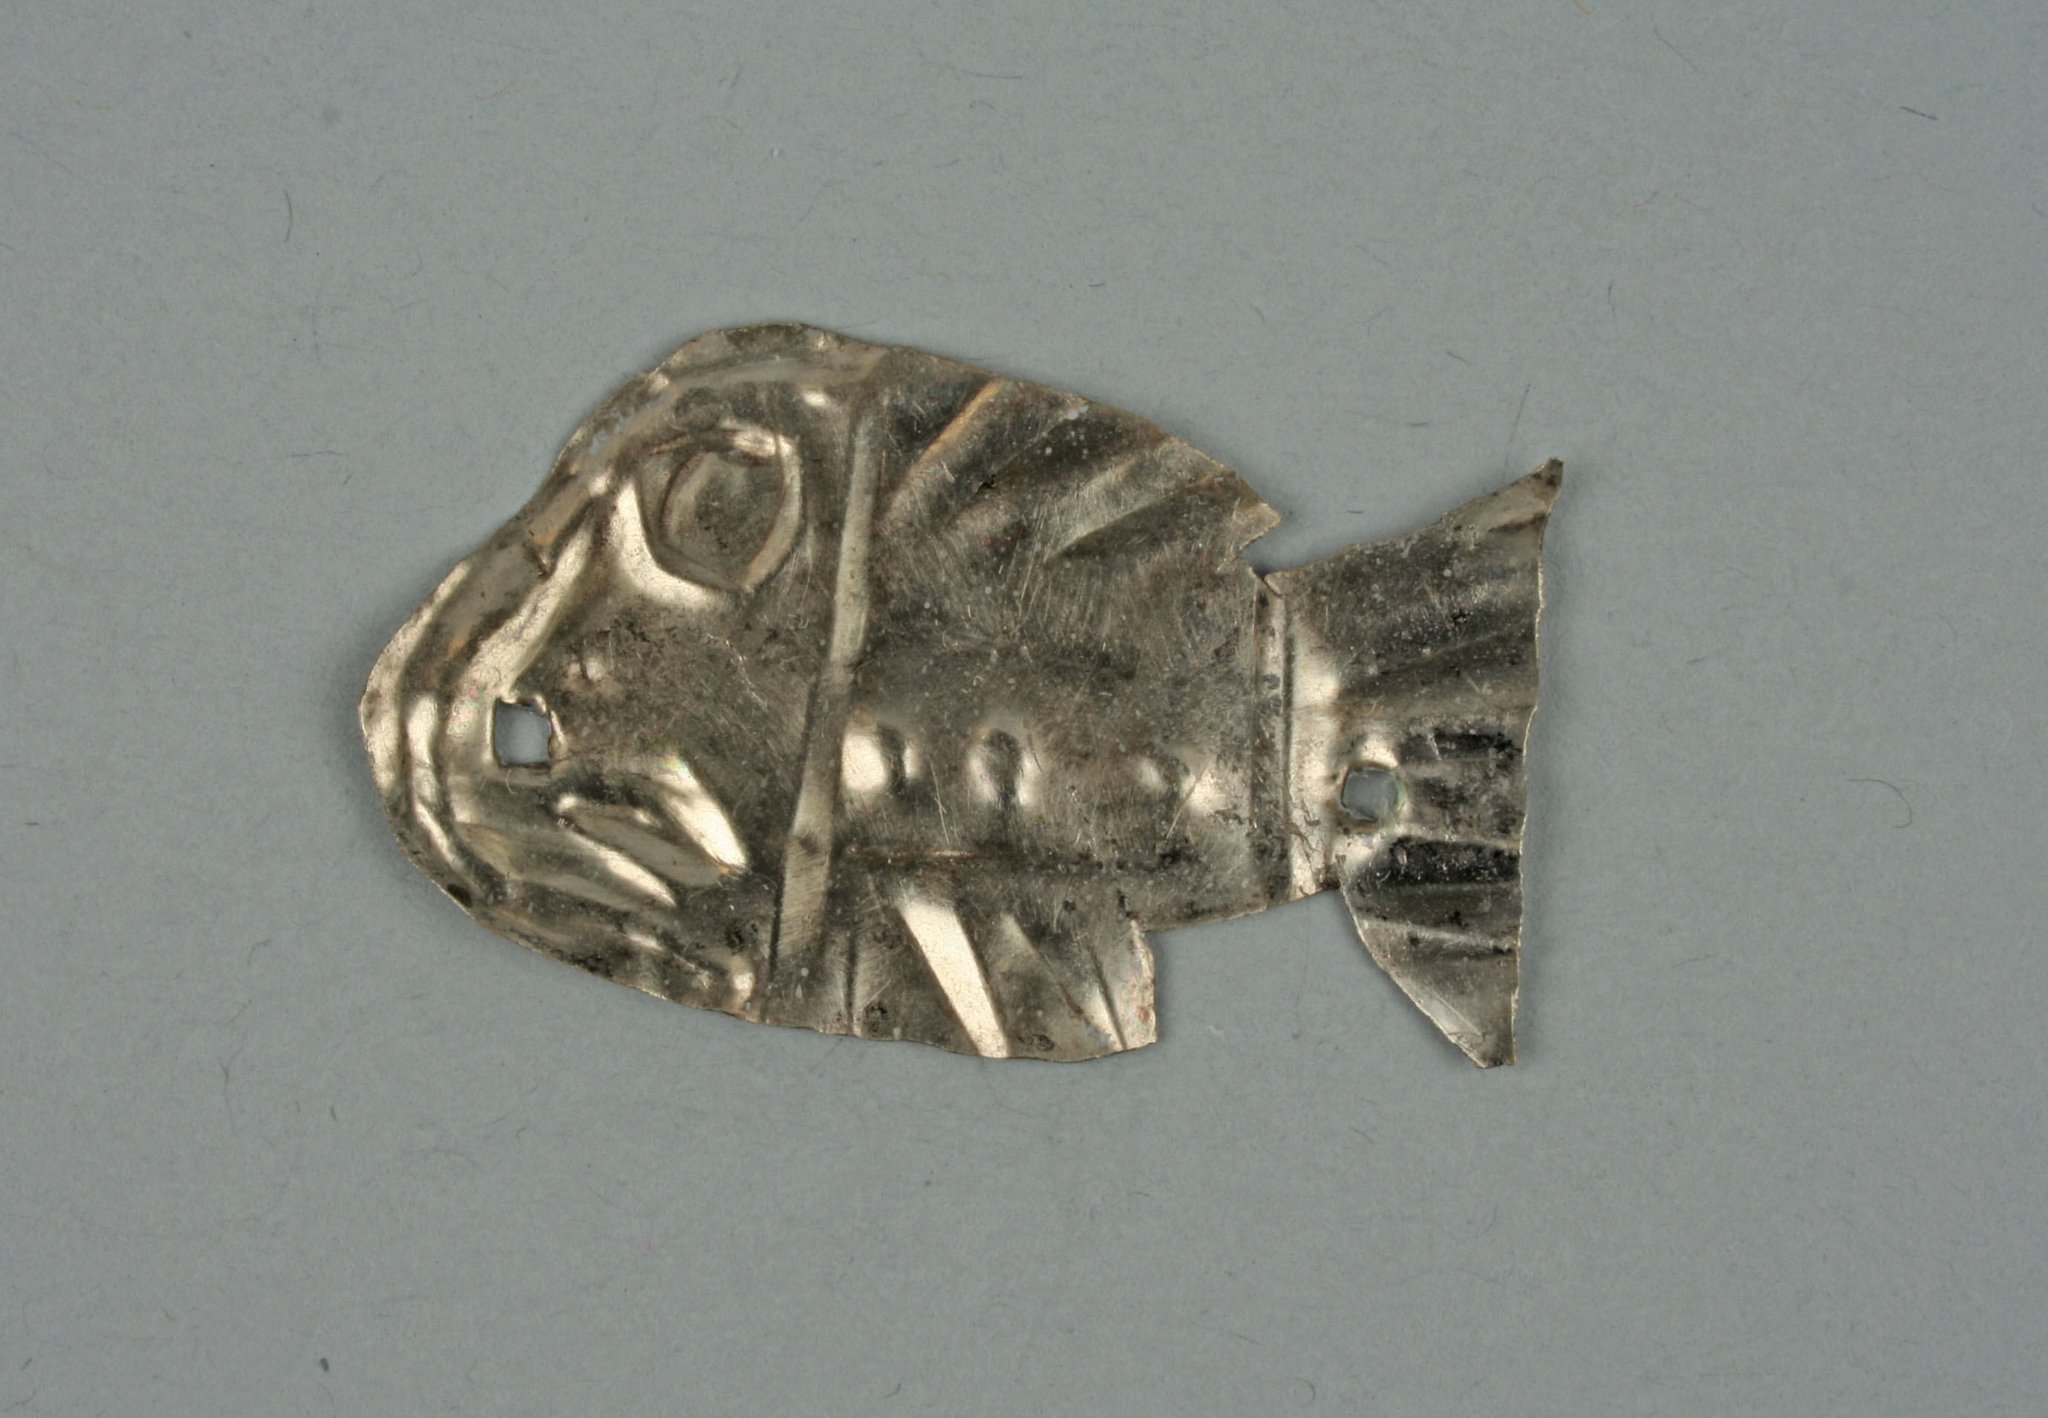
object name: ornament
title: Fish Ornament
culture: peruvian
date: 1001-1200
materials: silver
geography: peru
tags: fish